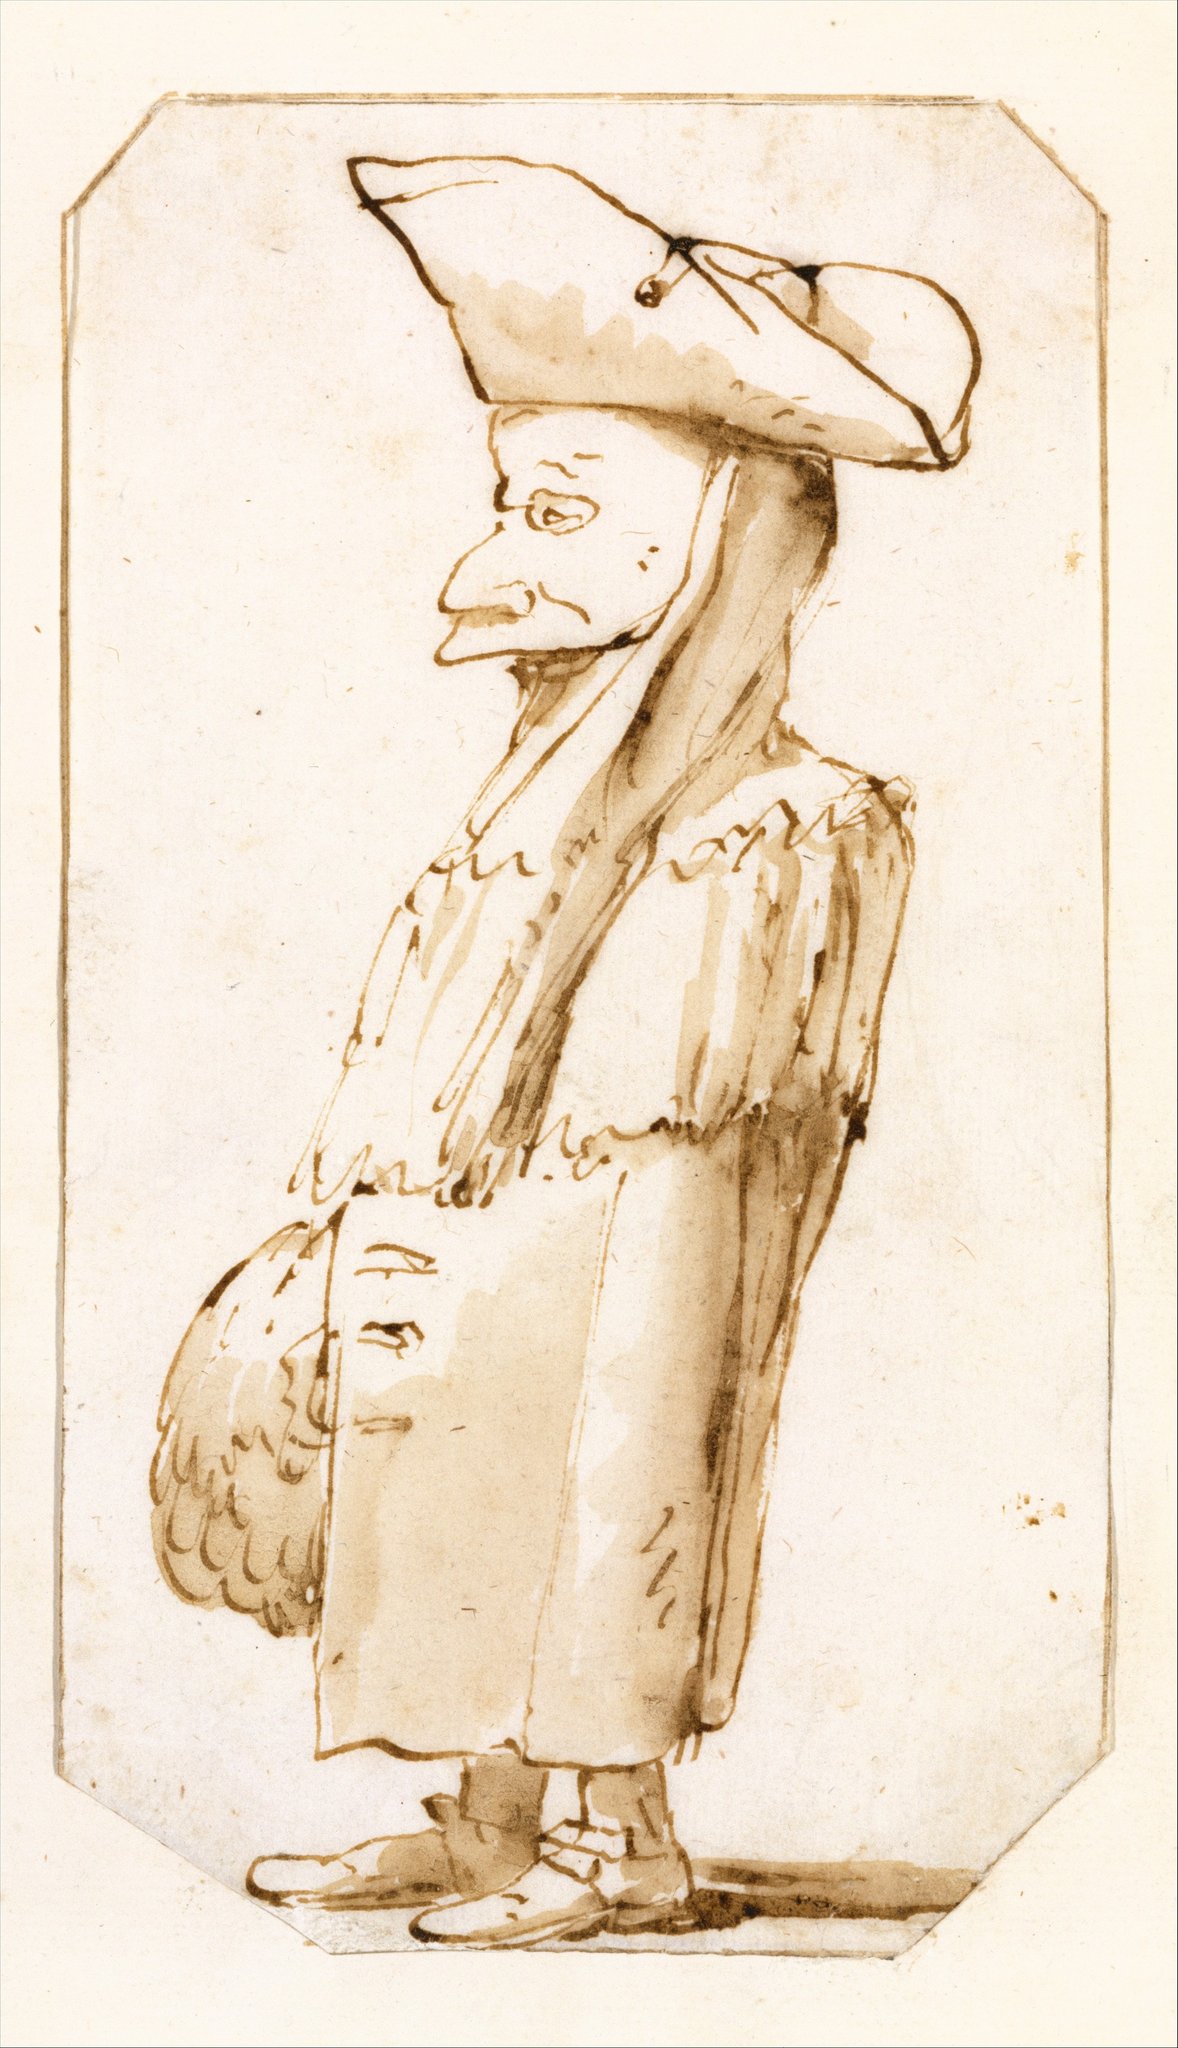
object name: drawing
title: Caricature of a Man in a Mask and a Tricorne, Standing in Profile to the Left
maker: giovanni battista tiepolo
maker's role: artist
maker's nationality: italian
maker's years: 1696-1770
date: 1760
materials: ink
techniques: pen, wash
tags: masks,men